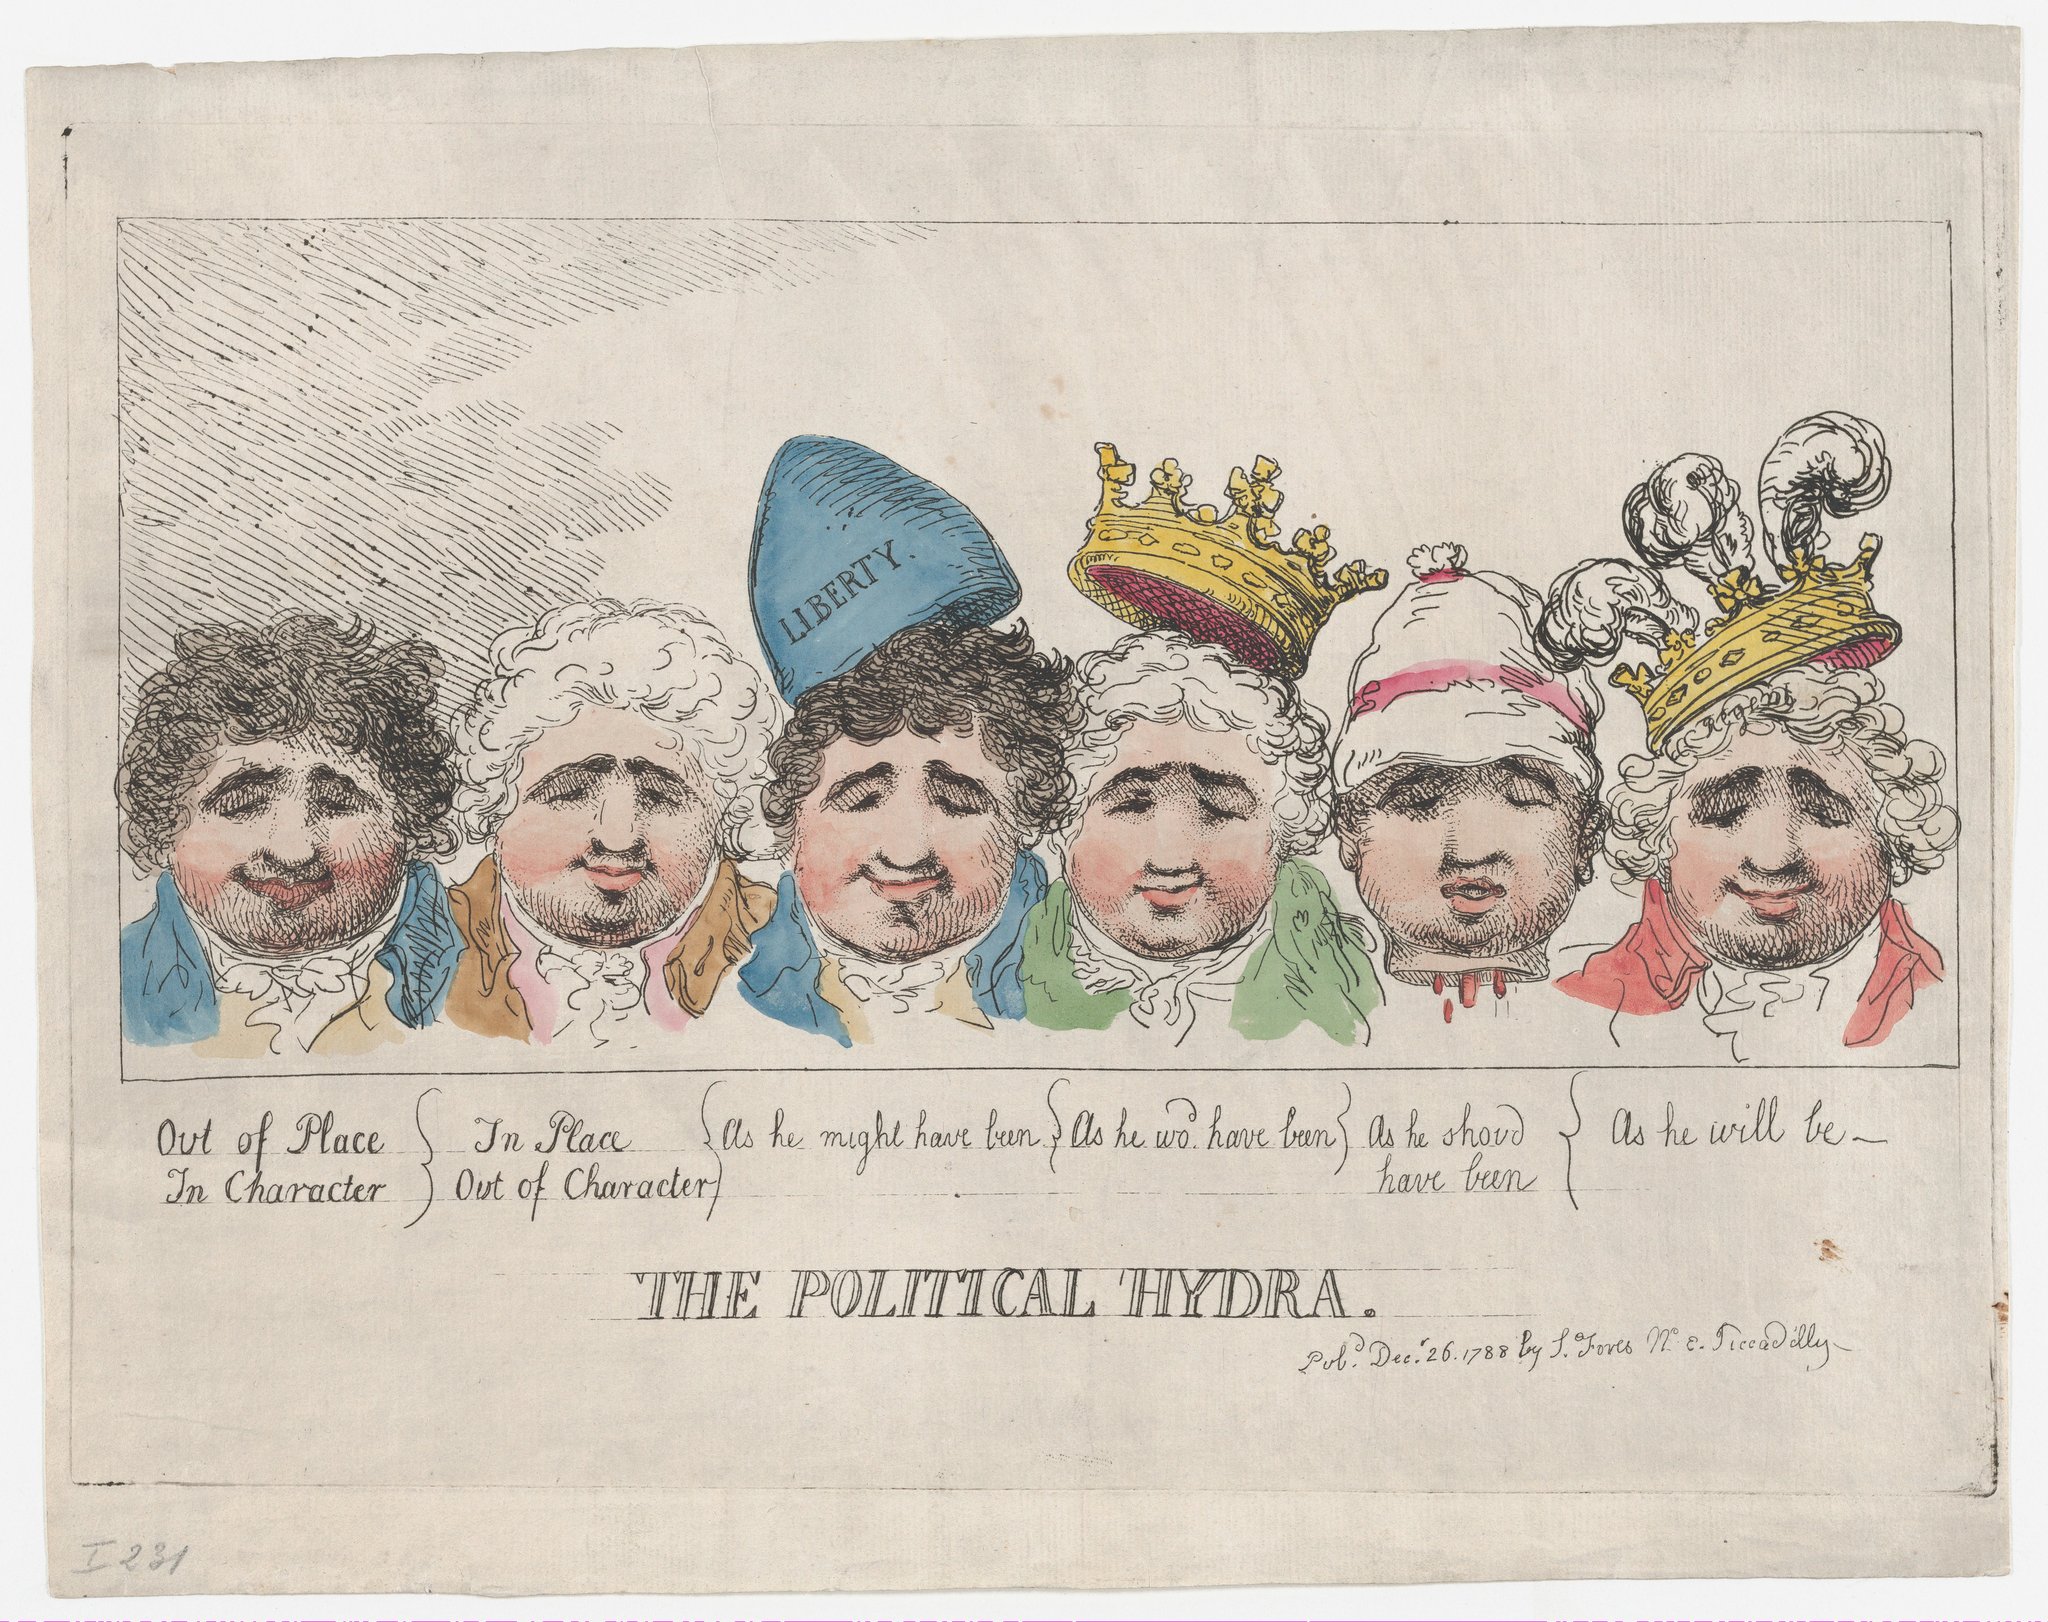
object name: print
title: The Political Hydra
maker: thomas rowlandson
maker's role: artist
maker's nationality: british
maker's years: 1757-1827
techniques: etching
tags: satire,men,politics